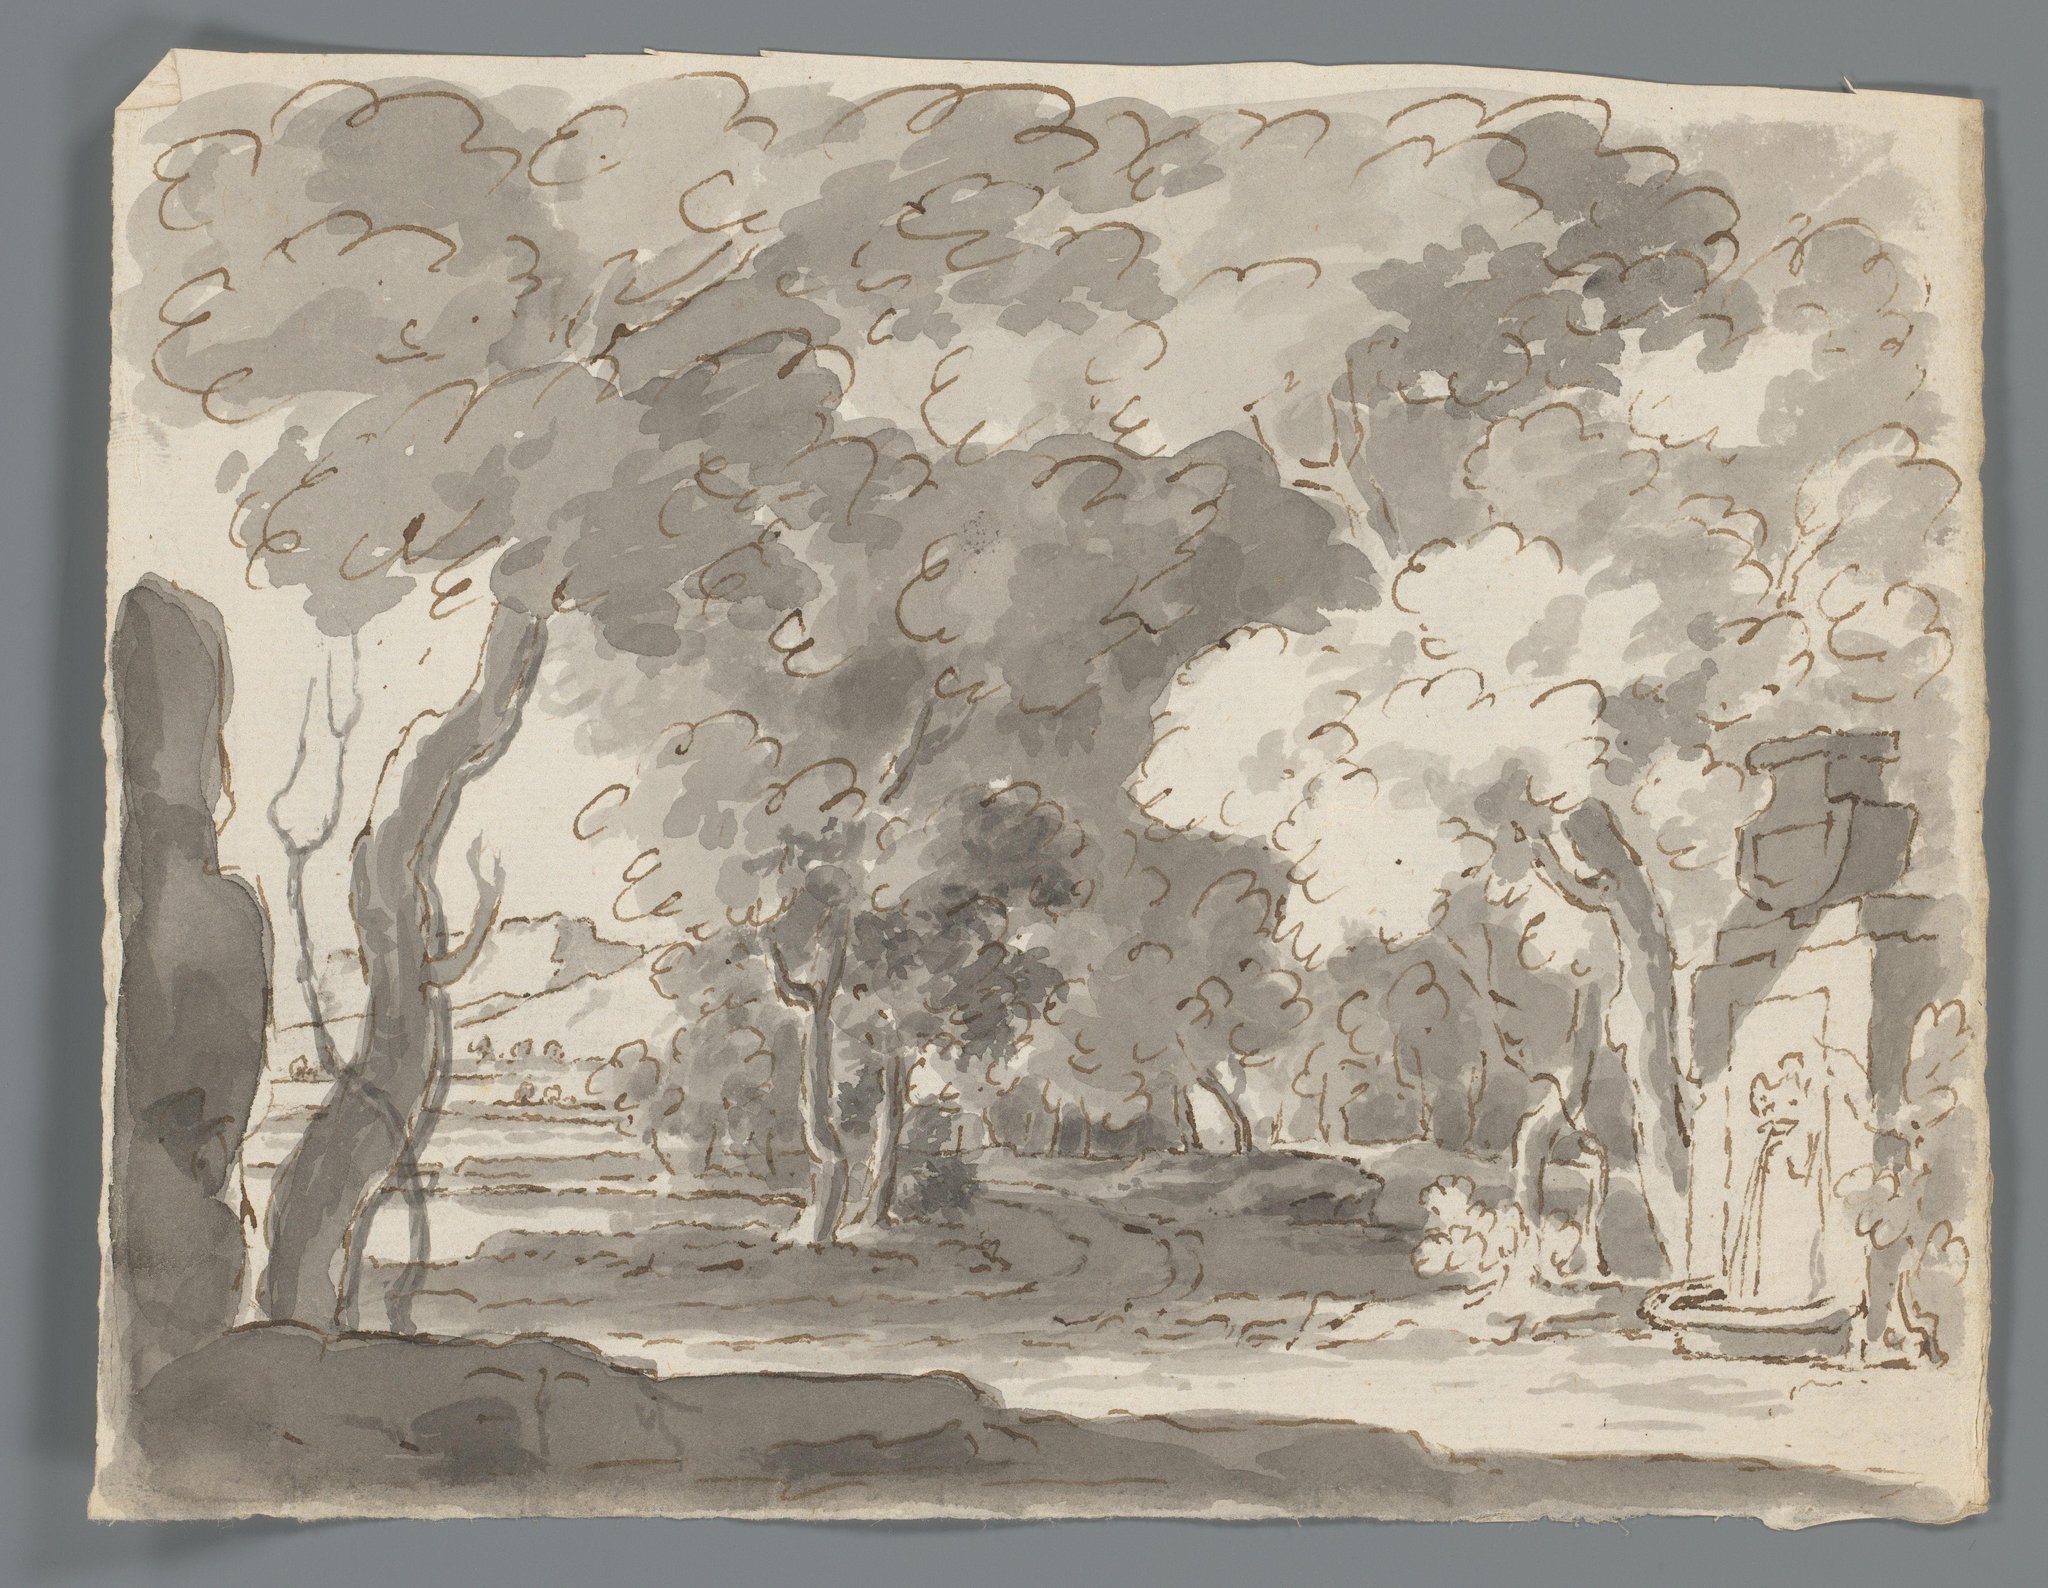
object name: drawing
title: Landschap met bomen en fontein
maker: matthijs balen (1684-1766)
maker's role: draughtsman, painter, print maker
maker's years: 1684-1766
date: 1694-1766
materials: paper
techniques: brush, pen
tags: city-view, and landscape with man-made constructions, products of plants in general, ornamental fountain